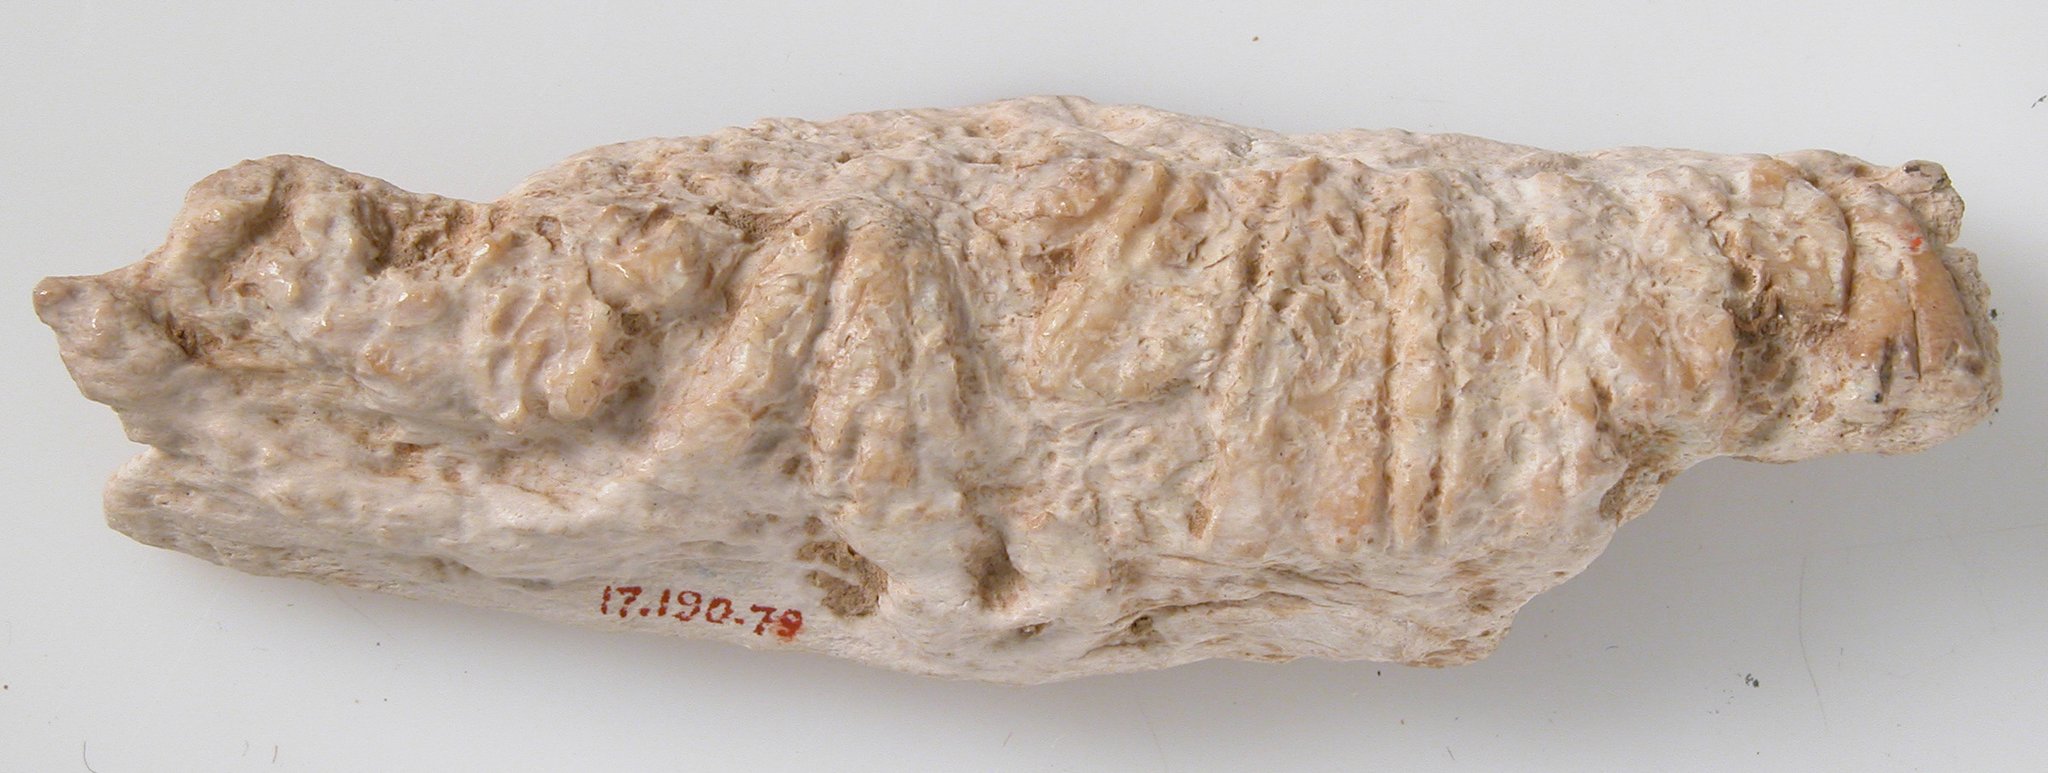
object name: fragment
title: Relief Fragment with Floral Design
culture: coptic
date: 501-700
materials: ivory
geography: egypt